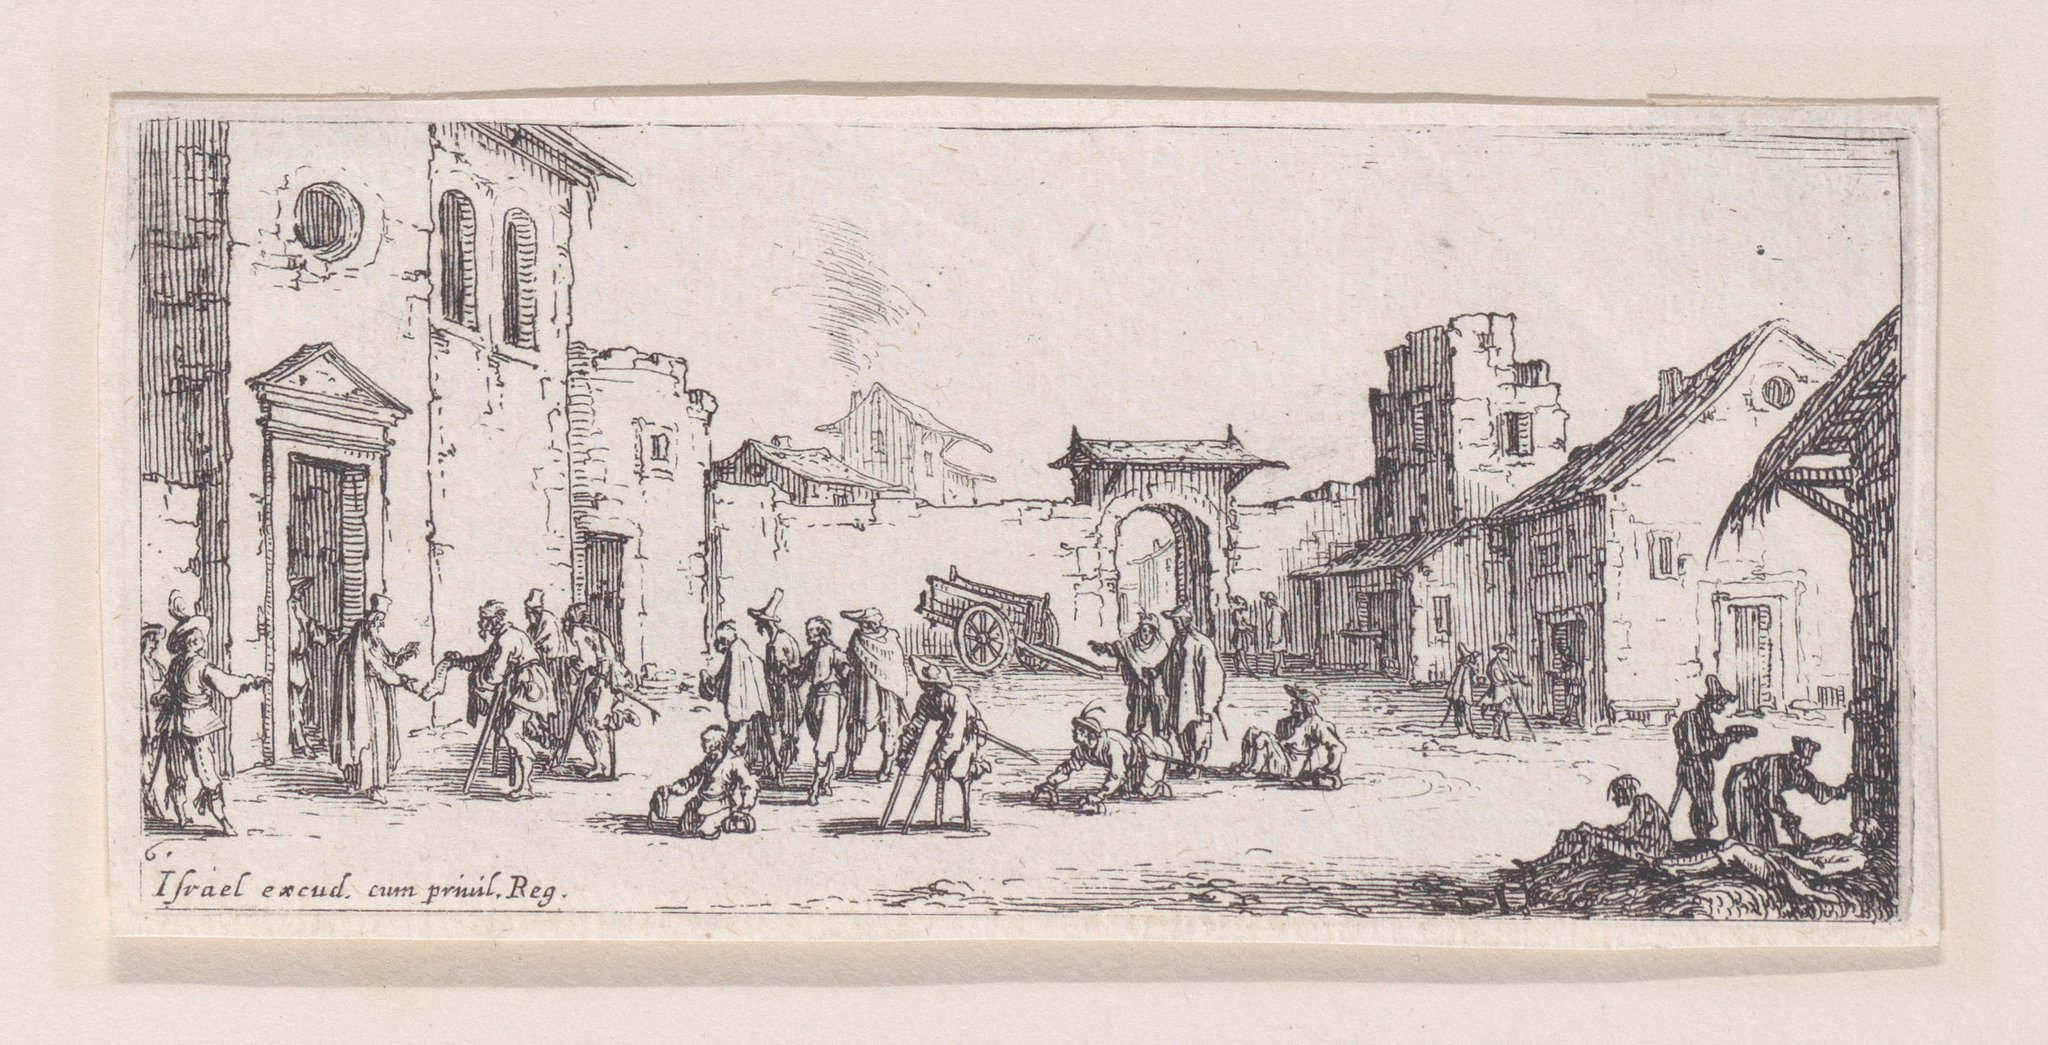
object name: print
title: L'Hopital (The Hospital), plate 6 from "Les Petites Misères de la Guerre" (The Little Miseries of War)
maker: jacques callot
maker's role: artist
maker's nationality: french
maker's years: 1592-1635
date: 1636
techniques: etching